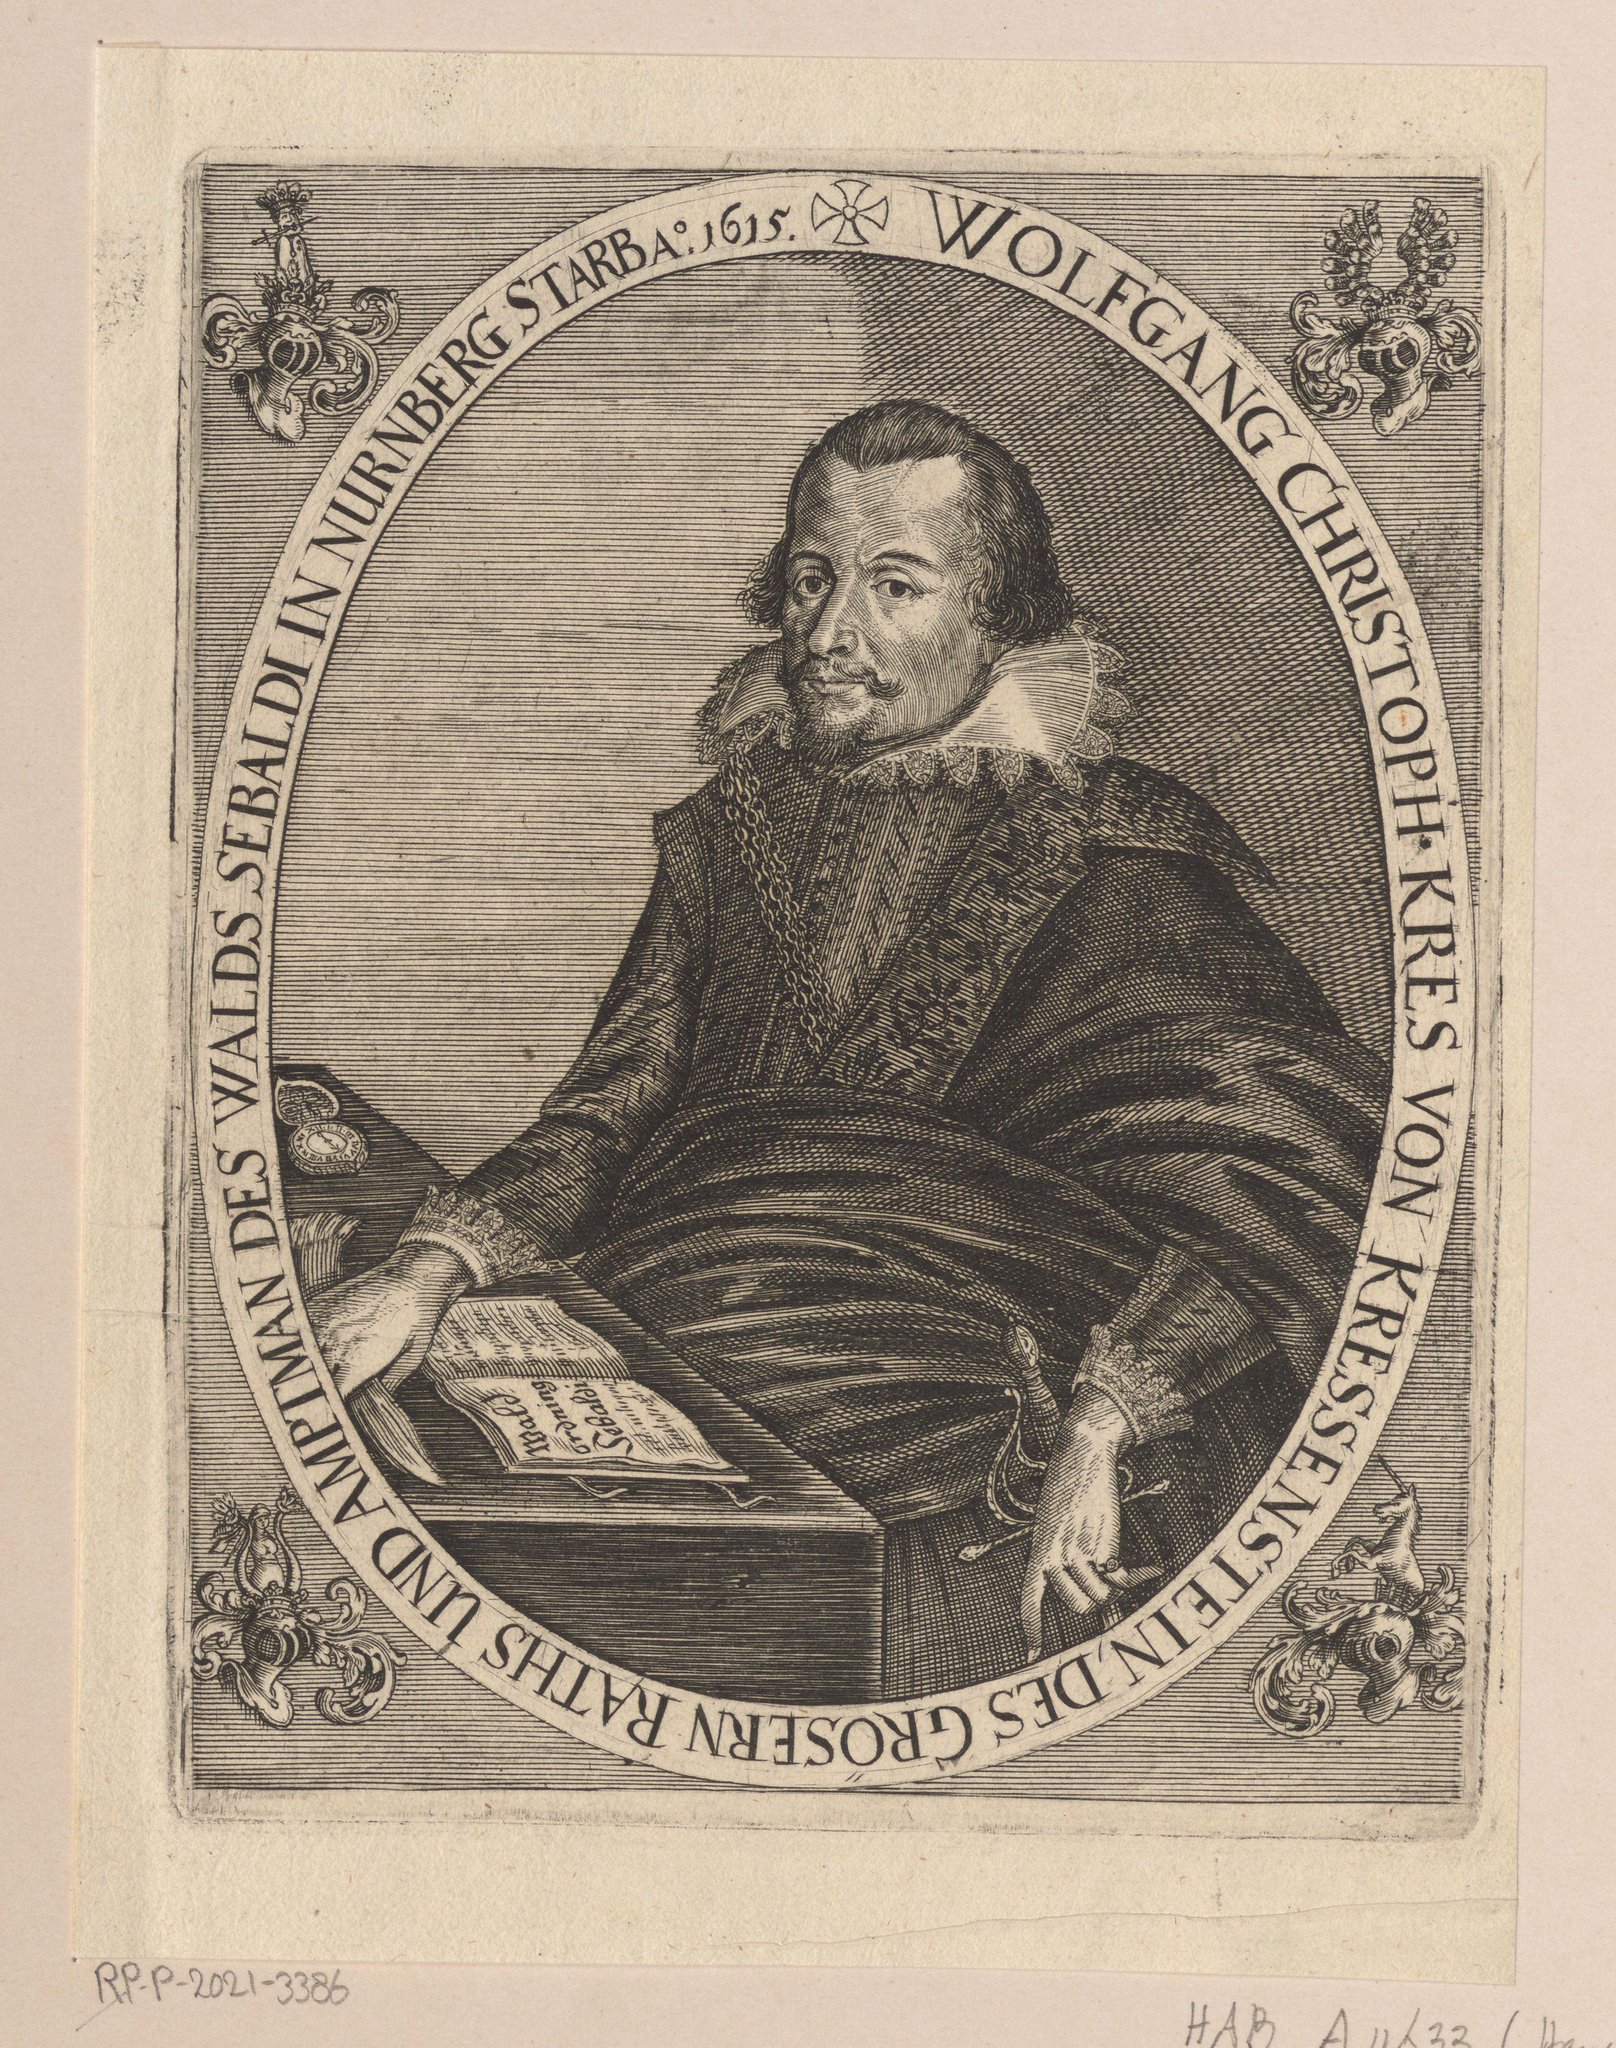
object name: print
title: Portret van Wolfgang Christoph Kreß von Kressenstein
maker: hans troschel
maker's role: draughtsman, print maker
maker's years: 1585-1628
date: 1615-1699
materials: paper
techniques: engraving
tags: helmet, historical persons, hacking and thrusting weapons: sword, book - mm - book open